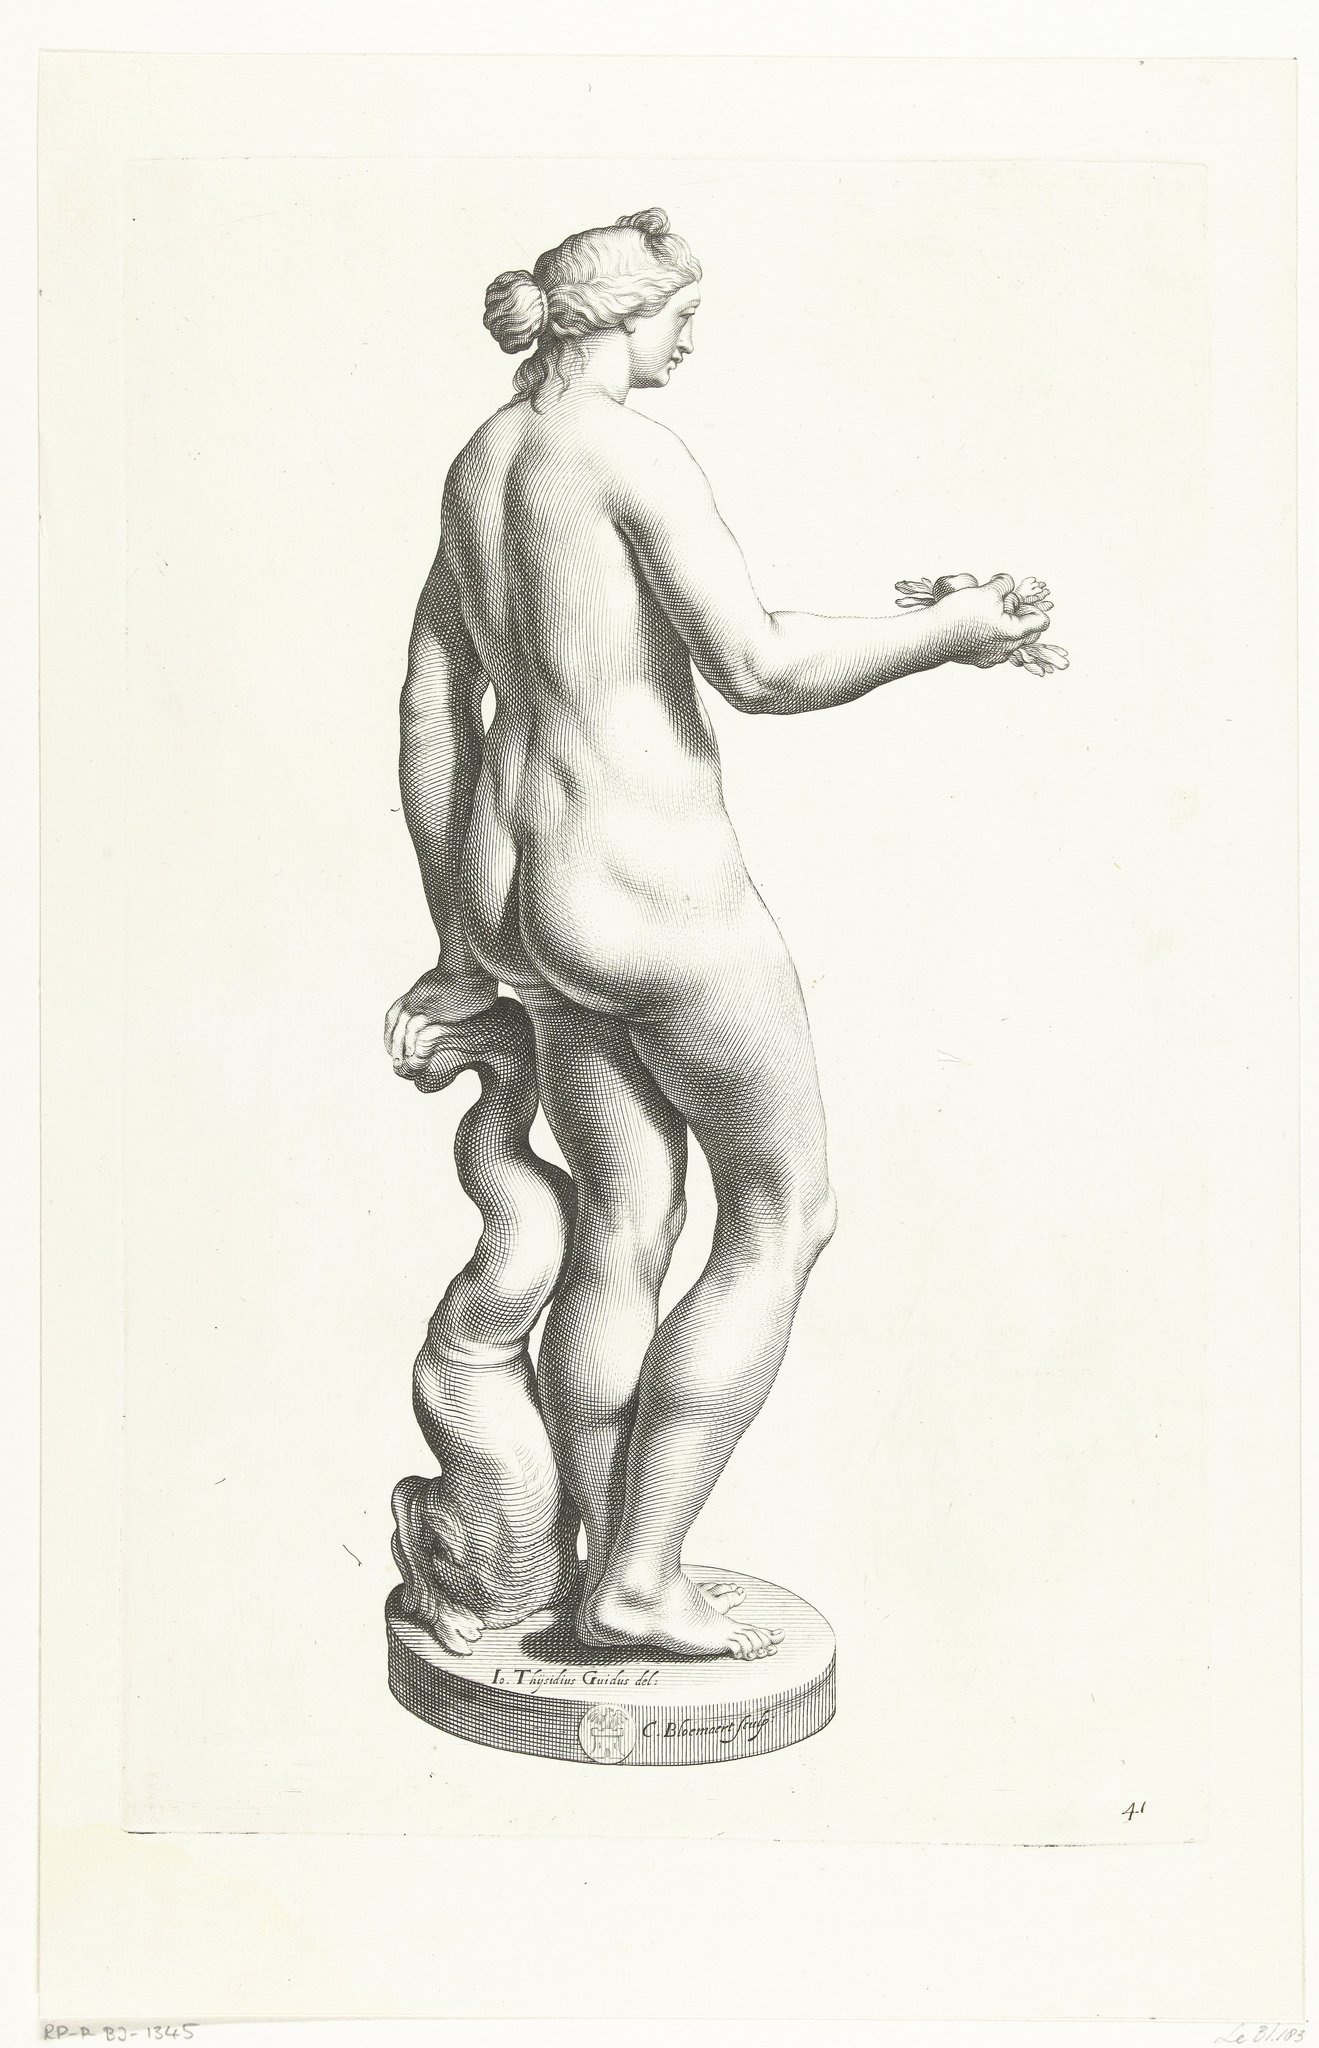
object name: print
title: Venus met fruit in haar handen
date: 1636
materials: paper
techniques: engraving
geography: rome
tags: piece of sculpture, reproduction of a piece of sculpture, (story of) venus (aphrodite)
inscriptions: collector's mark: Lugt 2228, number: ‘41’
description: Beeld van Venus, de godin van de liefde, naakt, op de rug gezien. In haar rechterhand houdt ze vruchten en bladeren. Het beeld is afkomstig uit de collectie van Vincenzo Giustiniani, wiens wapen op de sokkel te zien is.